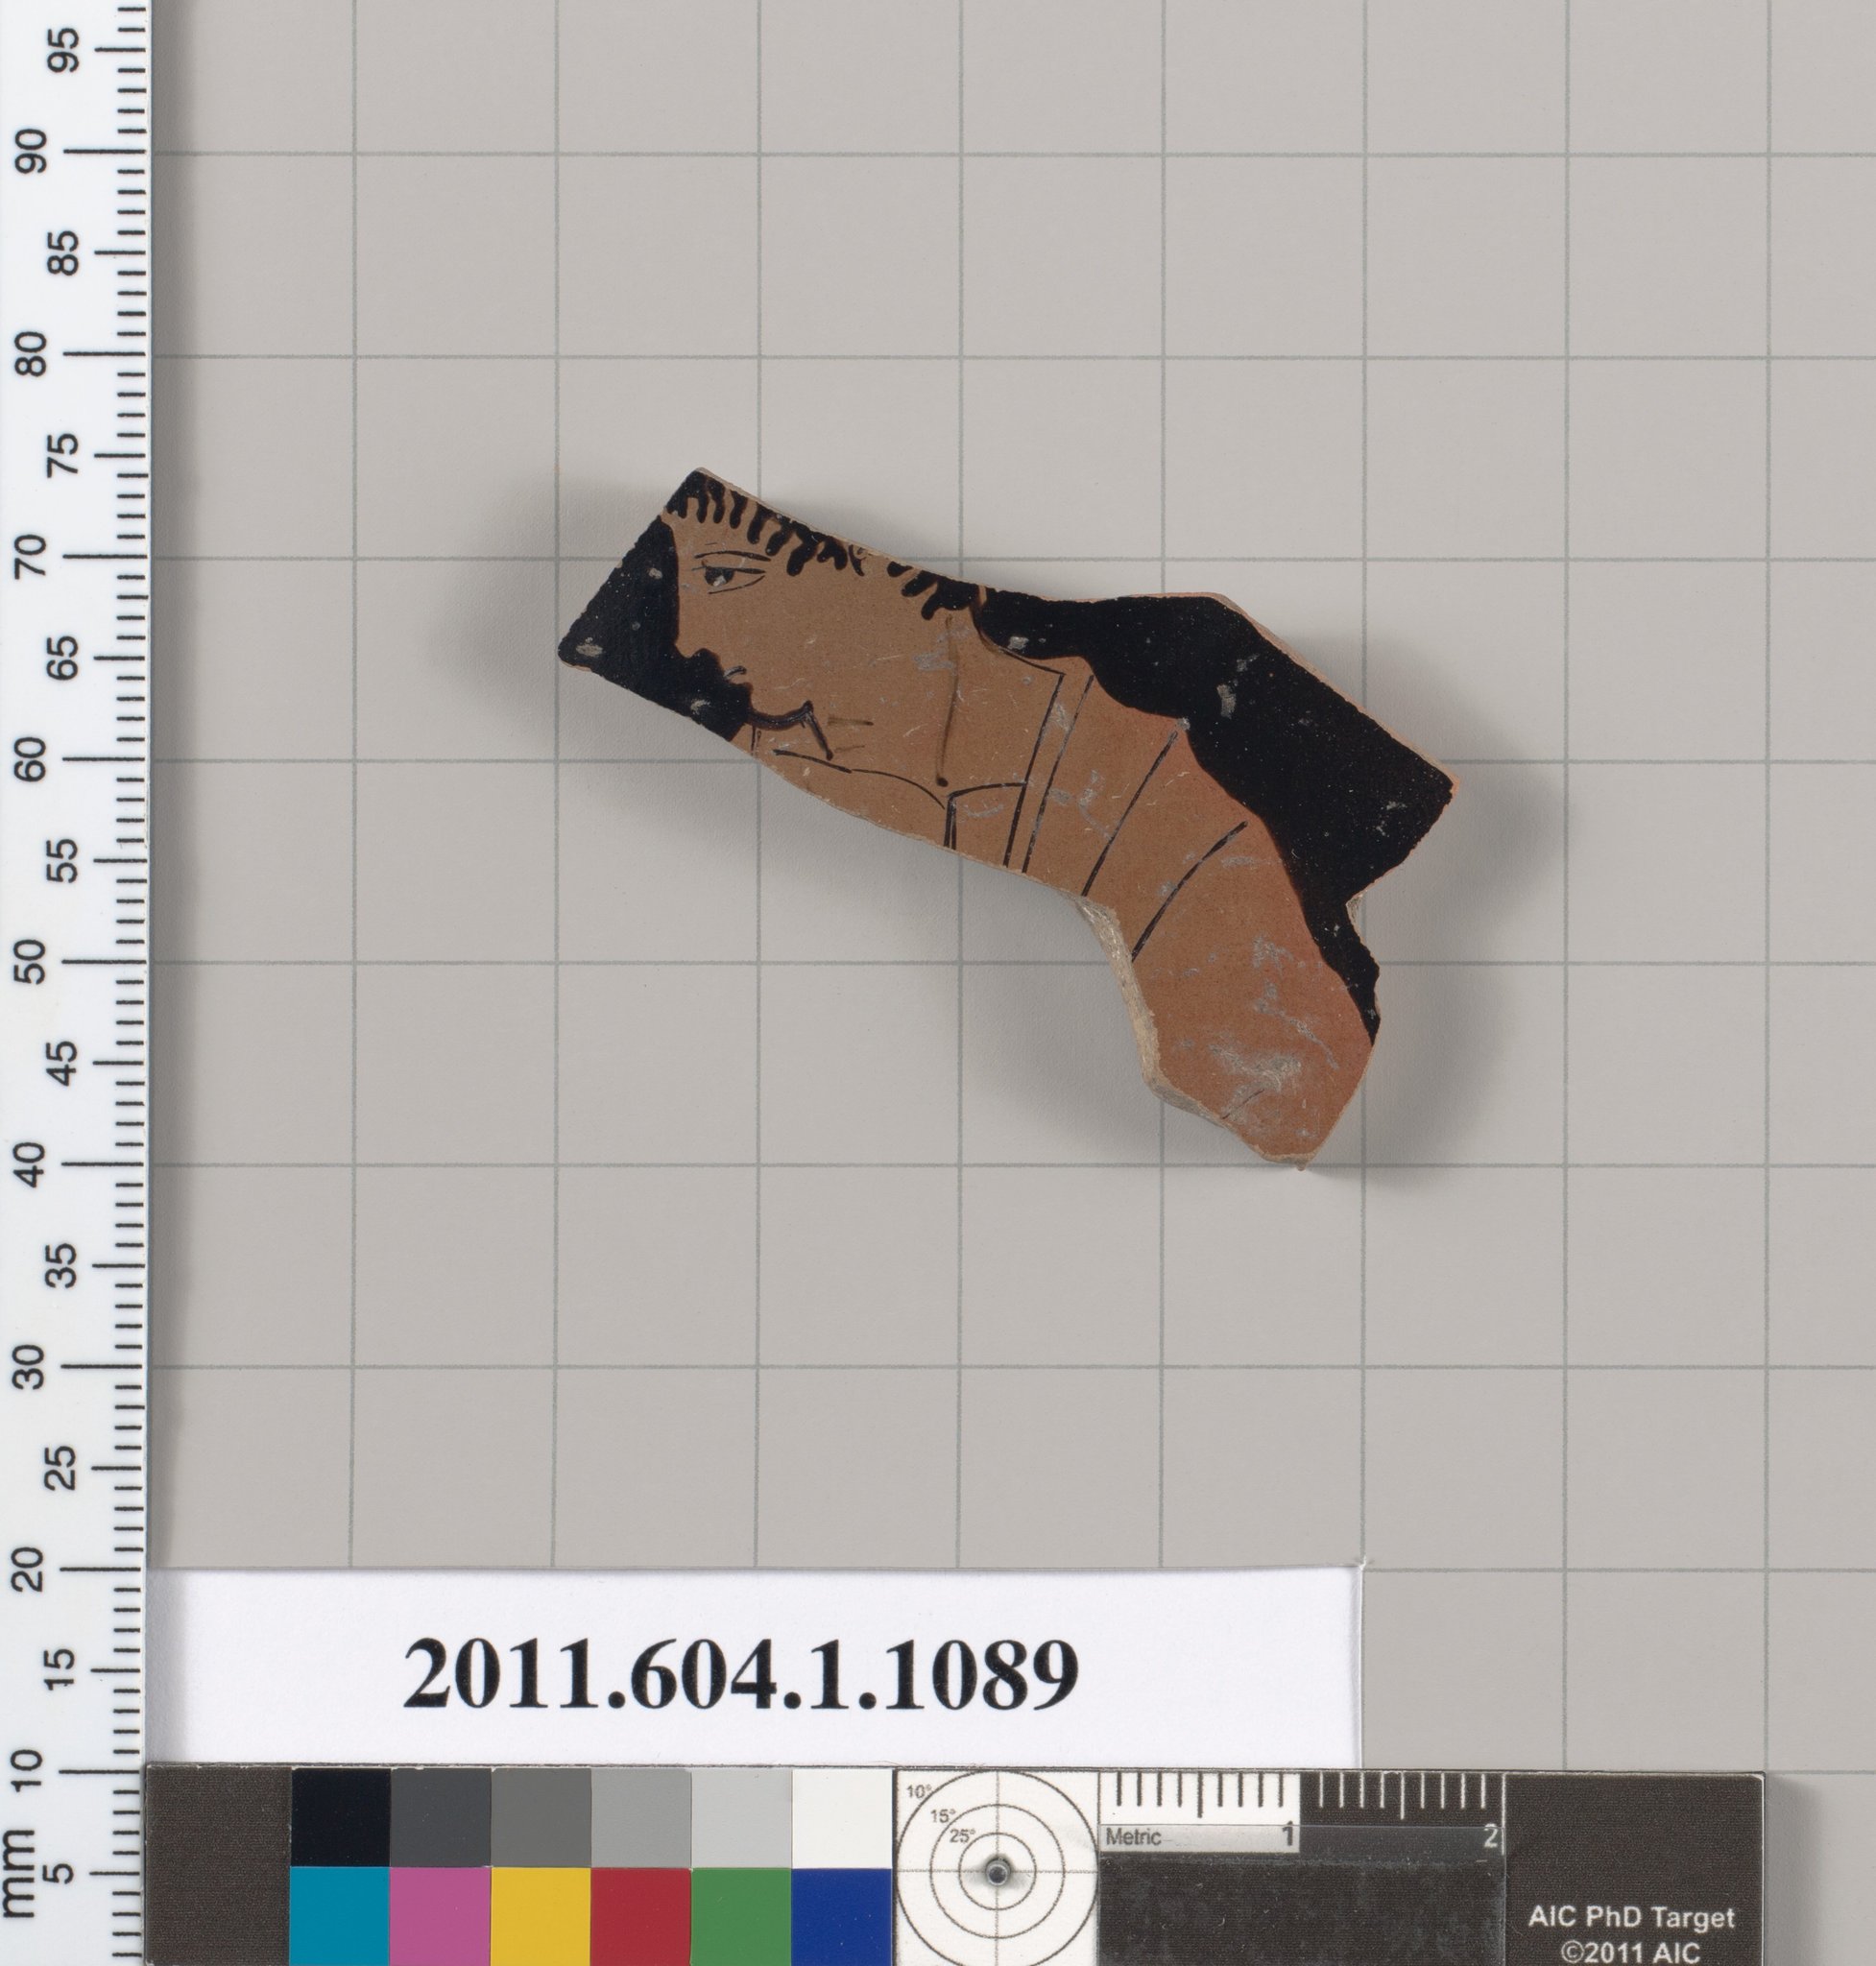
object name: kylix fragment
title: Terracotta fragment of a kylix (drinking cup)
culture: greek, attic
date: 475-451 BCE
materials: terracotta